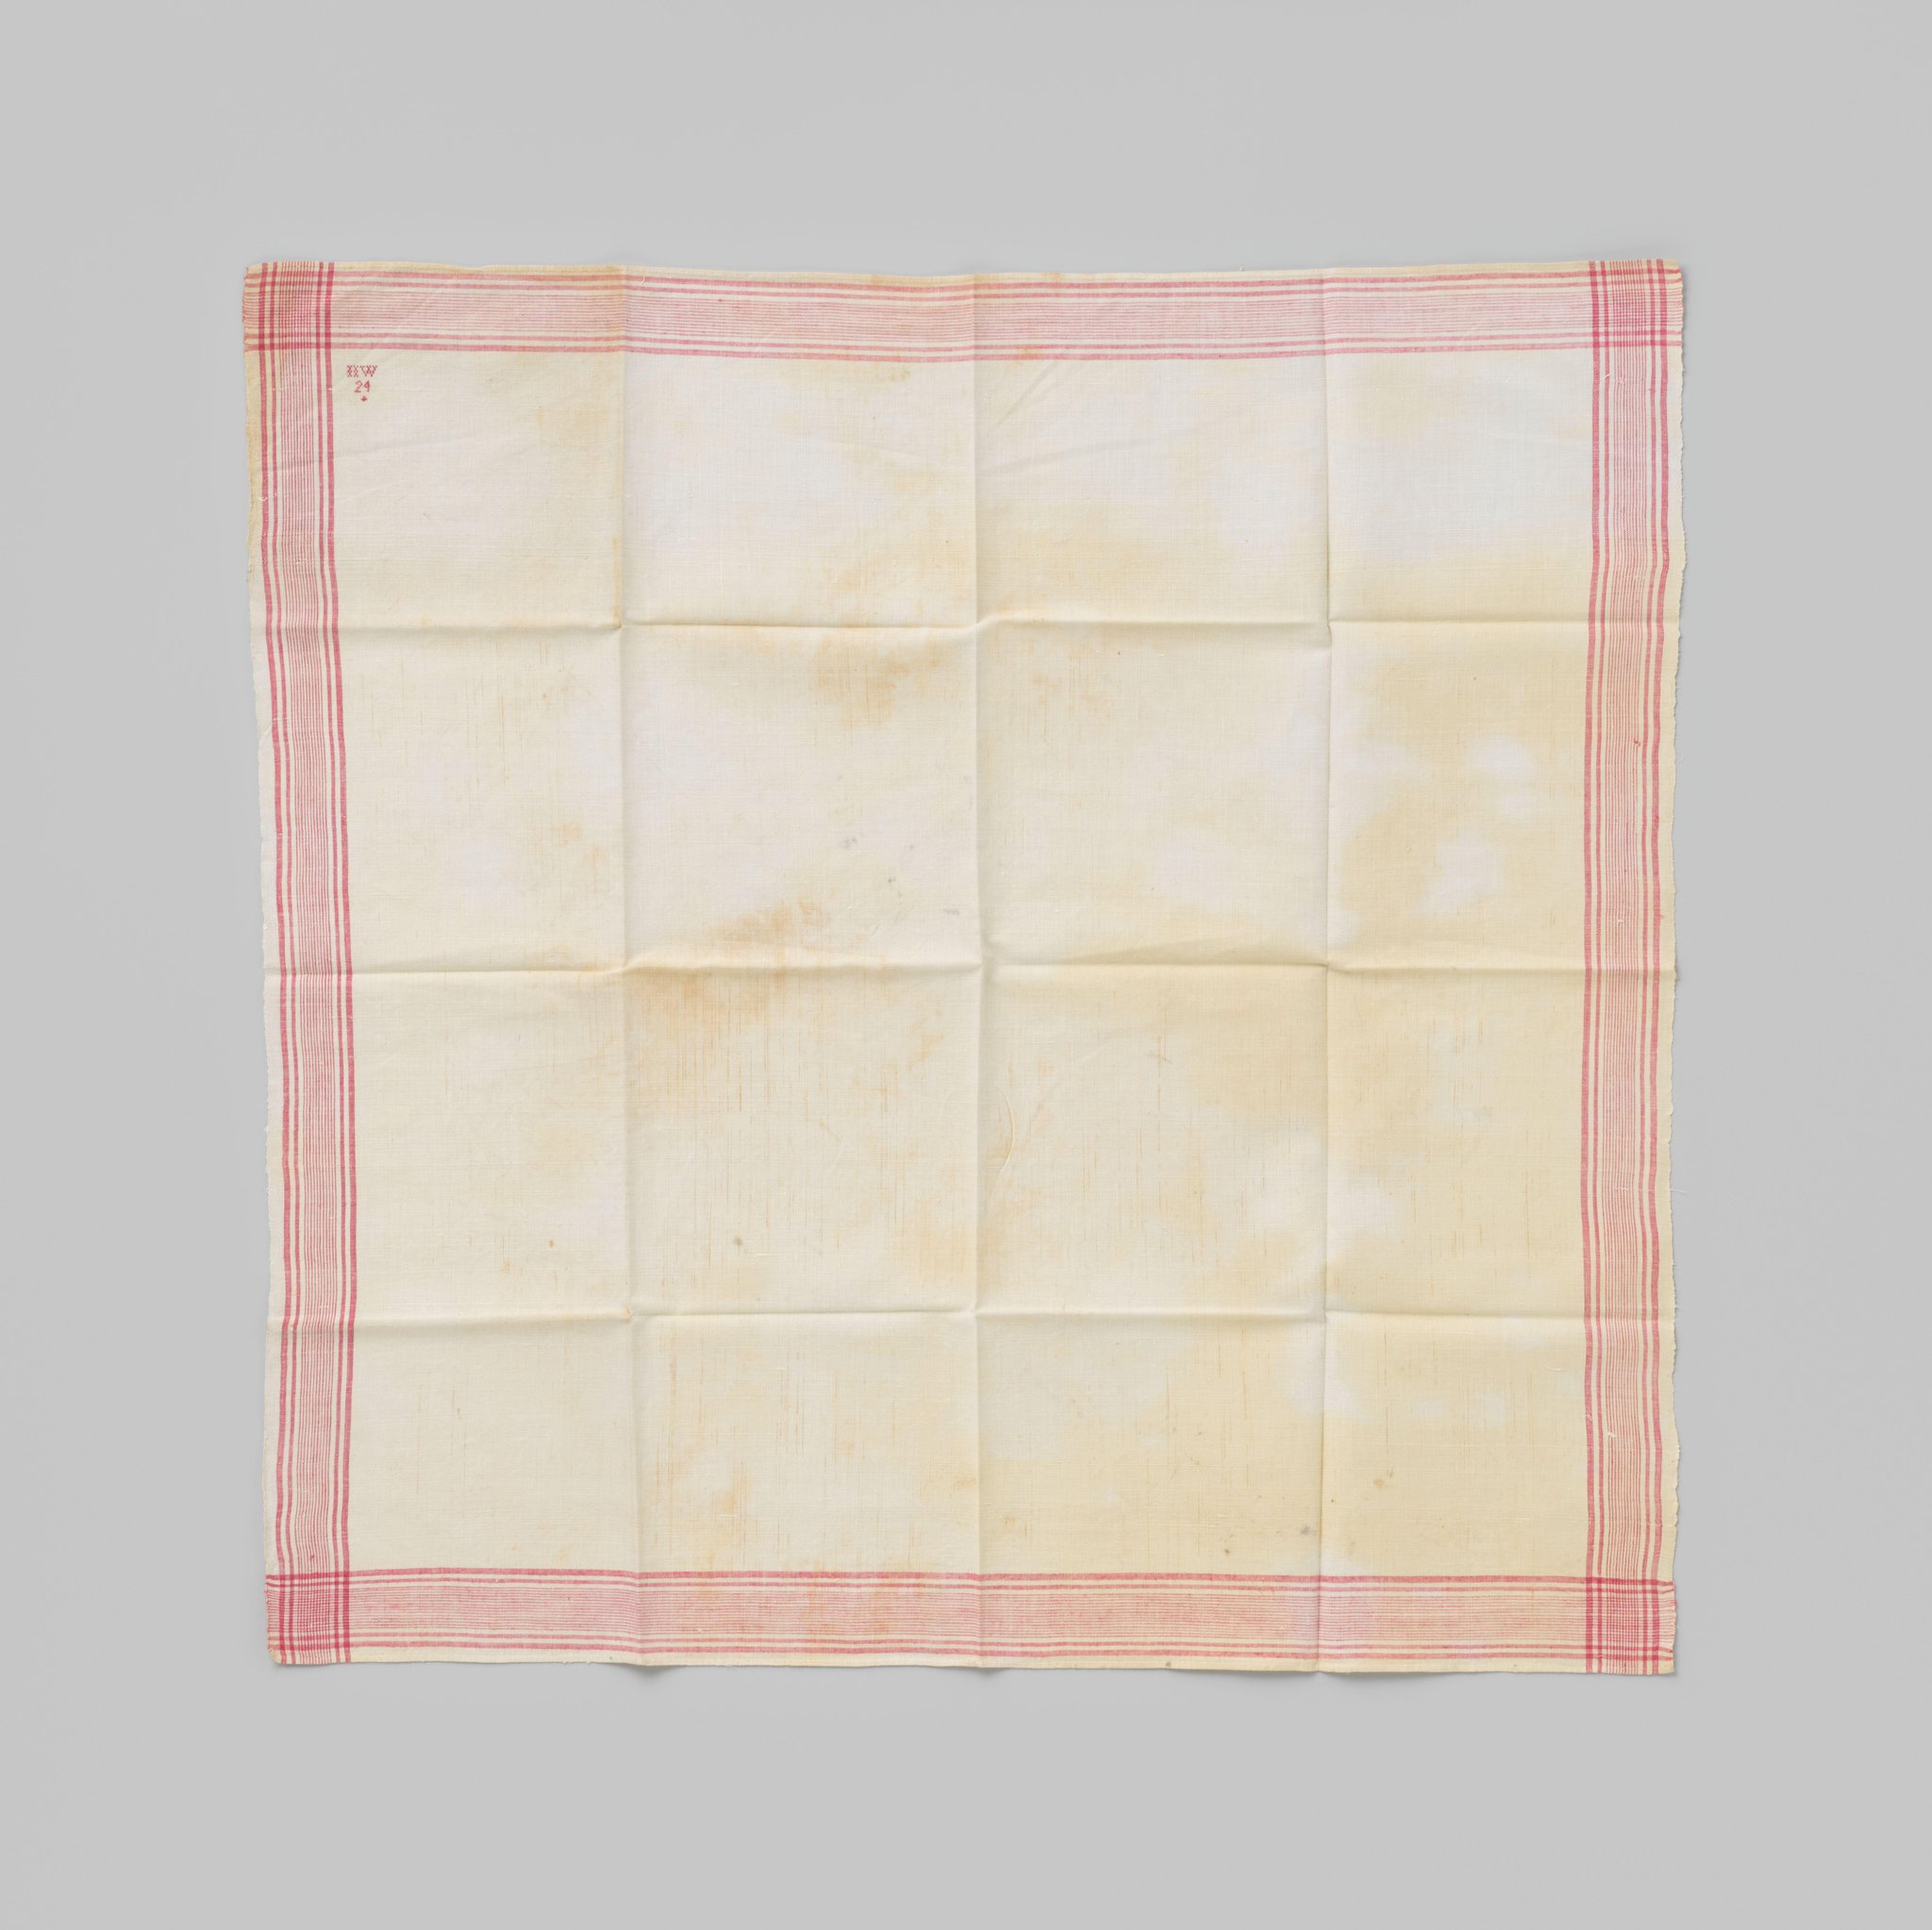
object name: kitchen towel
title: Theedoek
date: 1831-1850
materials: linen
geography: netherlands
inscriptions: mark: ‘HW24+’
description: Theedoek van linnen met een roodgestreepte rand. Merk HW24.